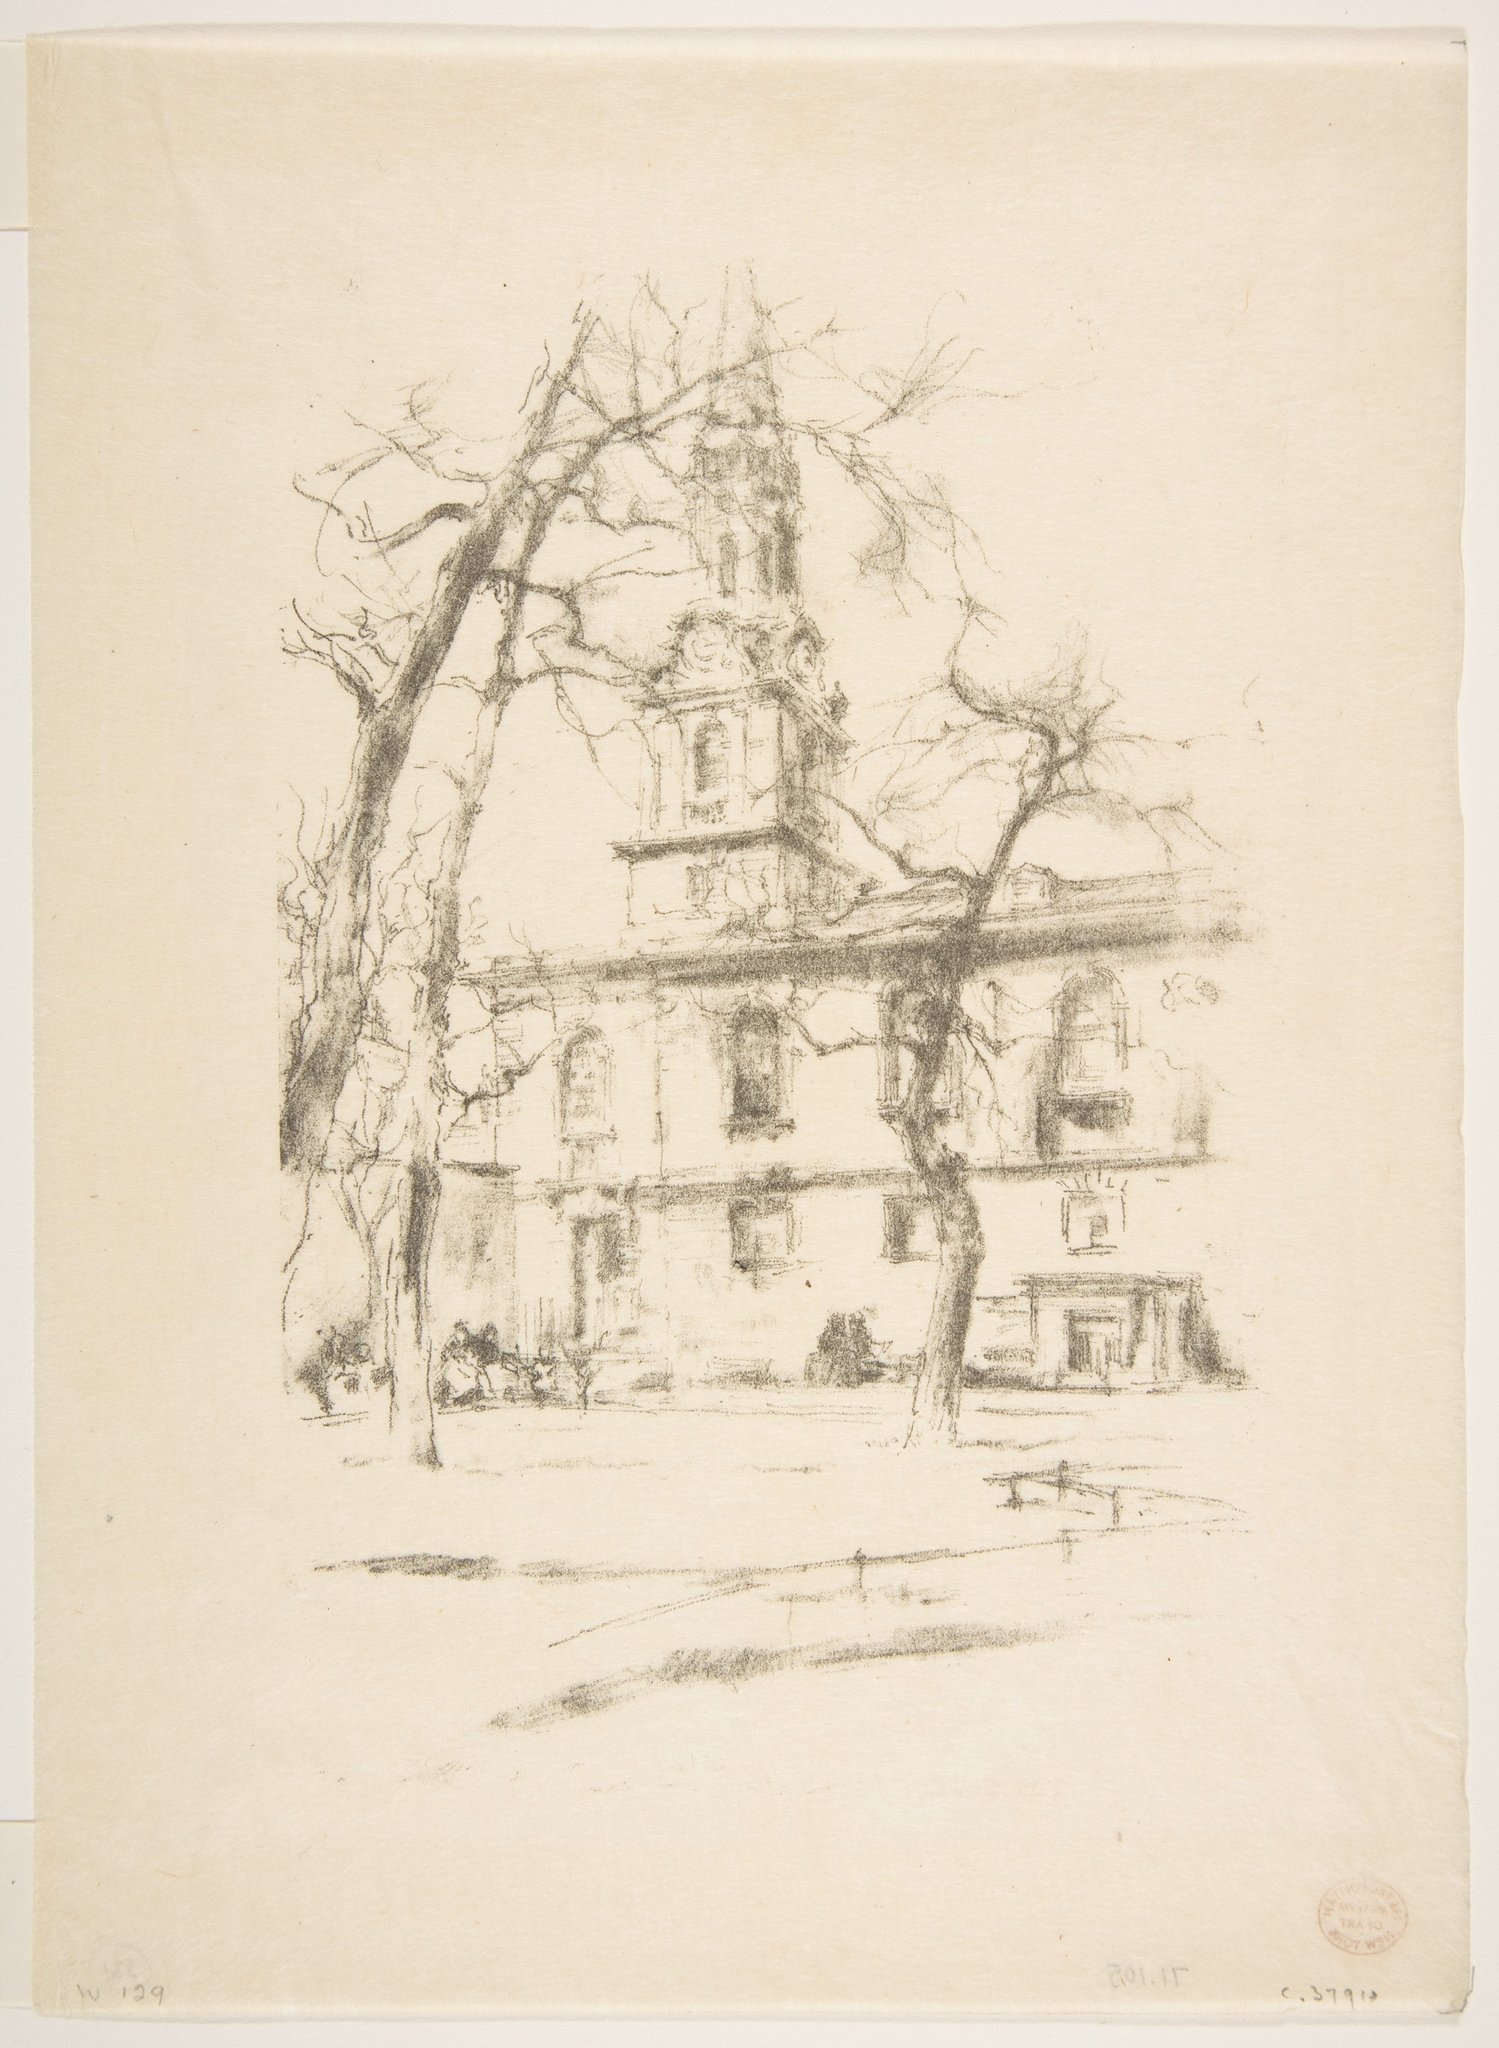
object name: print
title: St. Giles-in-the-Fields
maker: james mcneill whistler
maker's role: artist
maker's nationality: american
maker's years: 1834-1903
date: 1896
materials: ink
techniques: printing, stumping, lithography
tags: buildings,churches